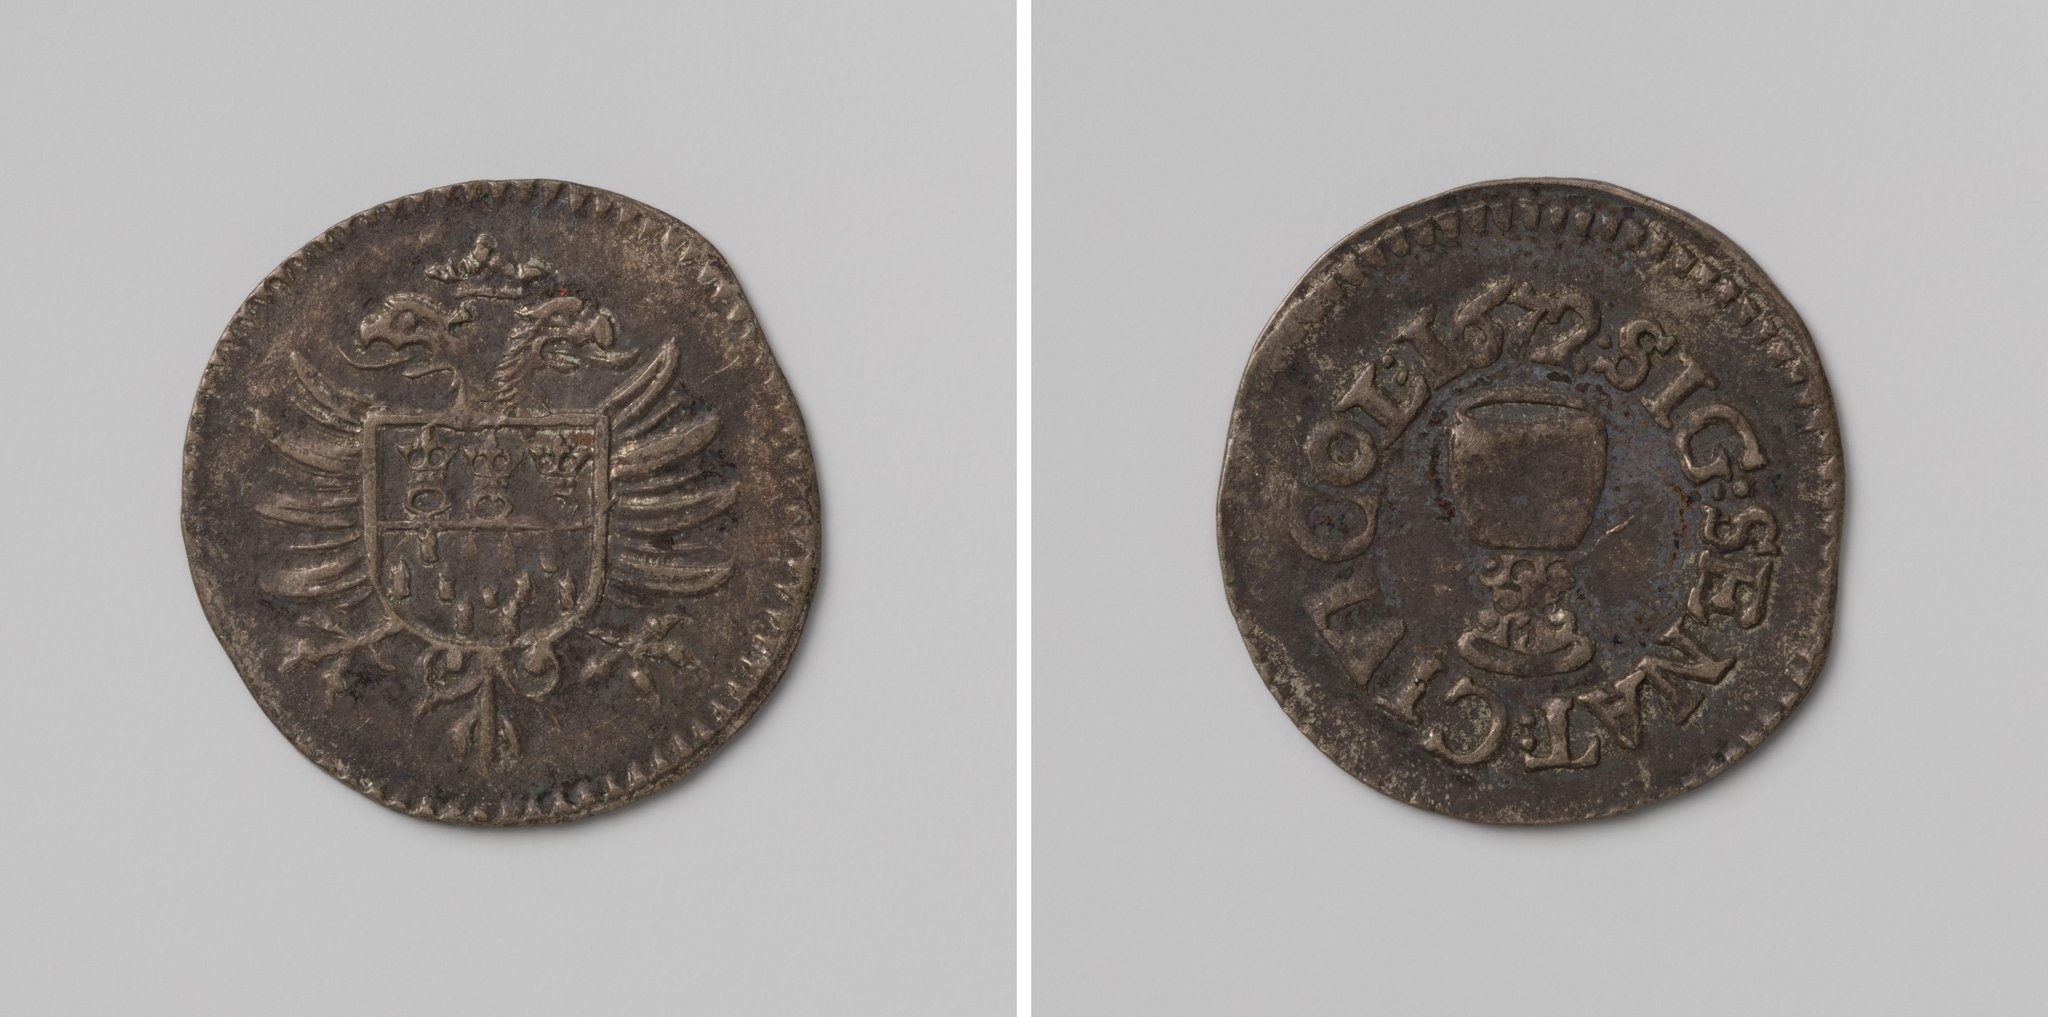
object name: council medal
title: Vroedschapspenning van de stad Keulen, penning uitgereikt aan de leden van de stadsraad recht gevend op een kan bier of wijn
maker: Anonymous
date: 1672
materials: metal alloy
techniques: striking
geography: cologne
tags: cologne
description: Penning. Voorzijde: gekroonde, dubbelkoppige adelaar met wapenschild voor borst in parelrand. Keerzijde: kelk binnen omschrift